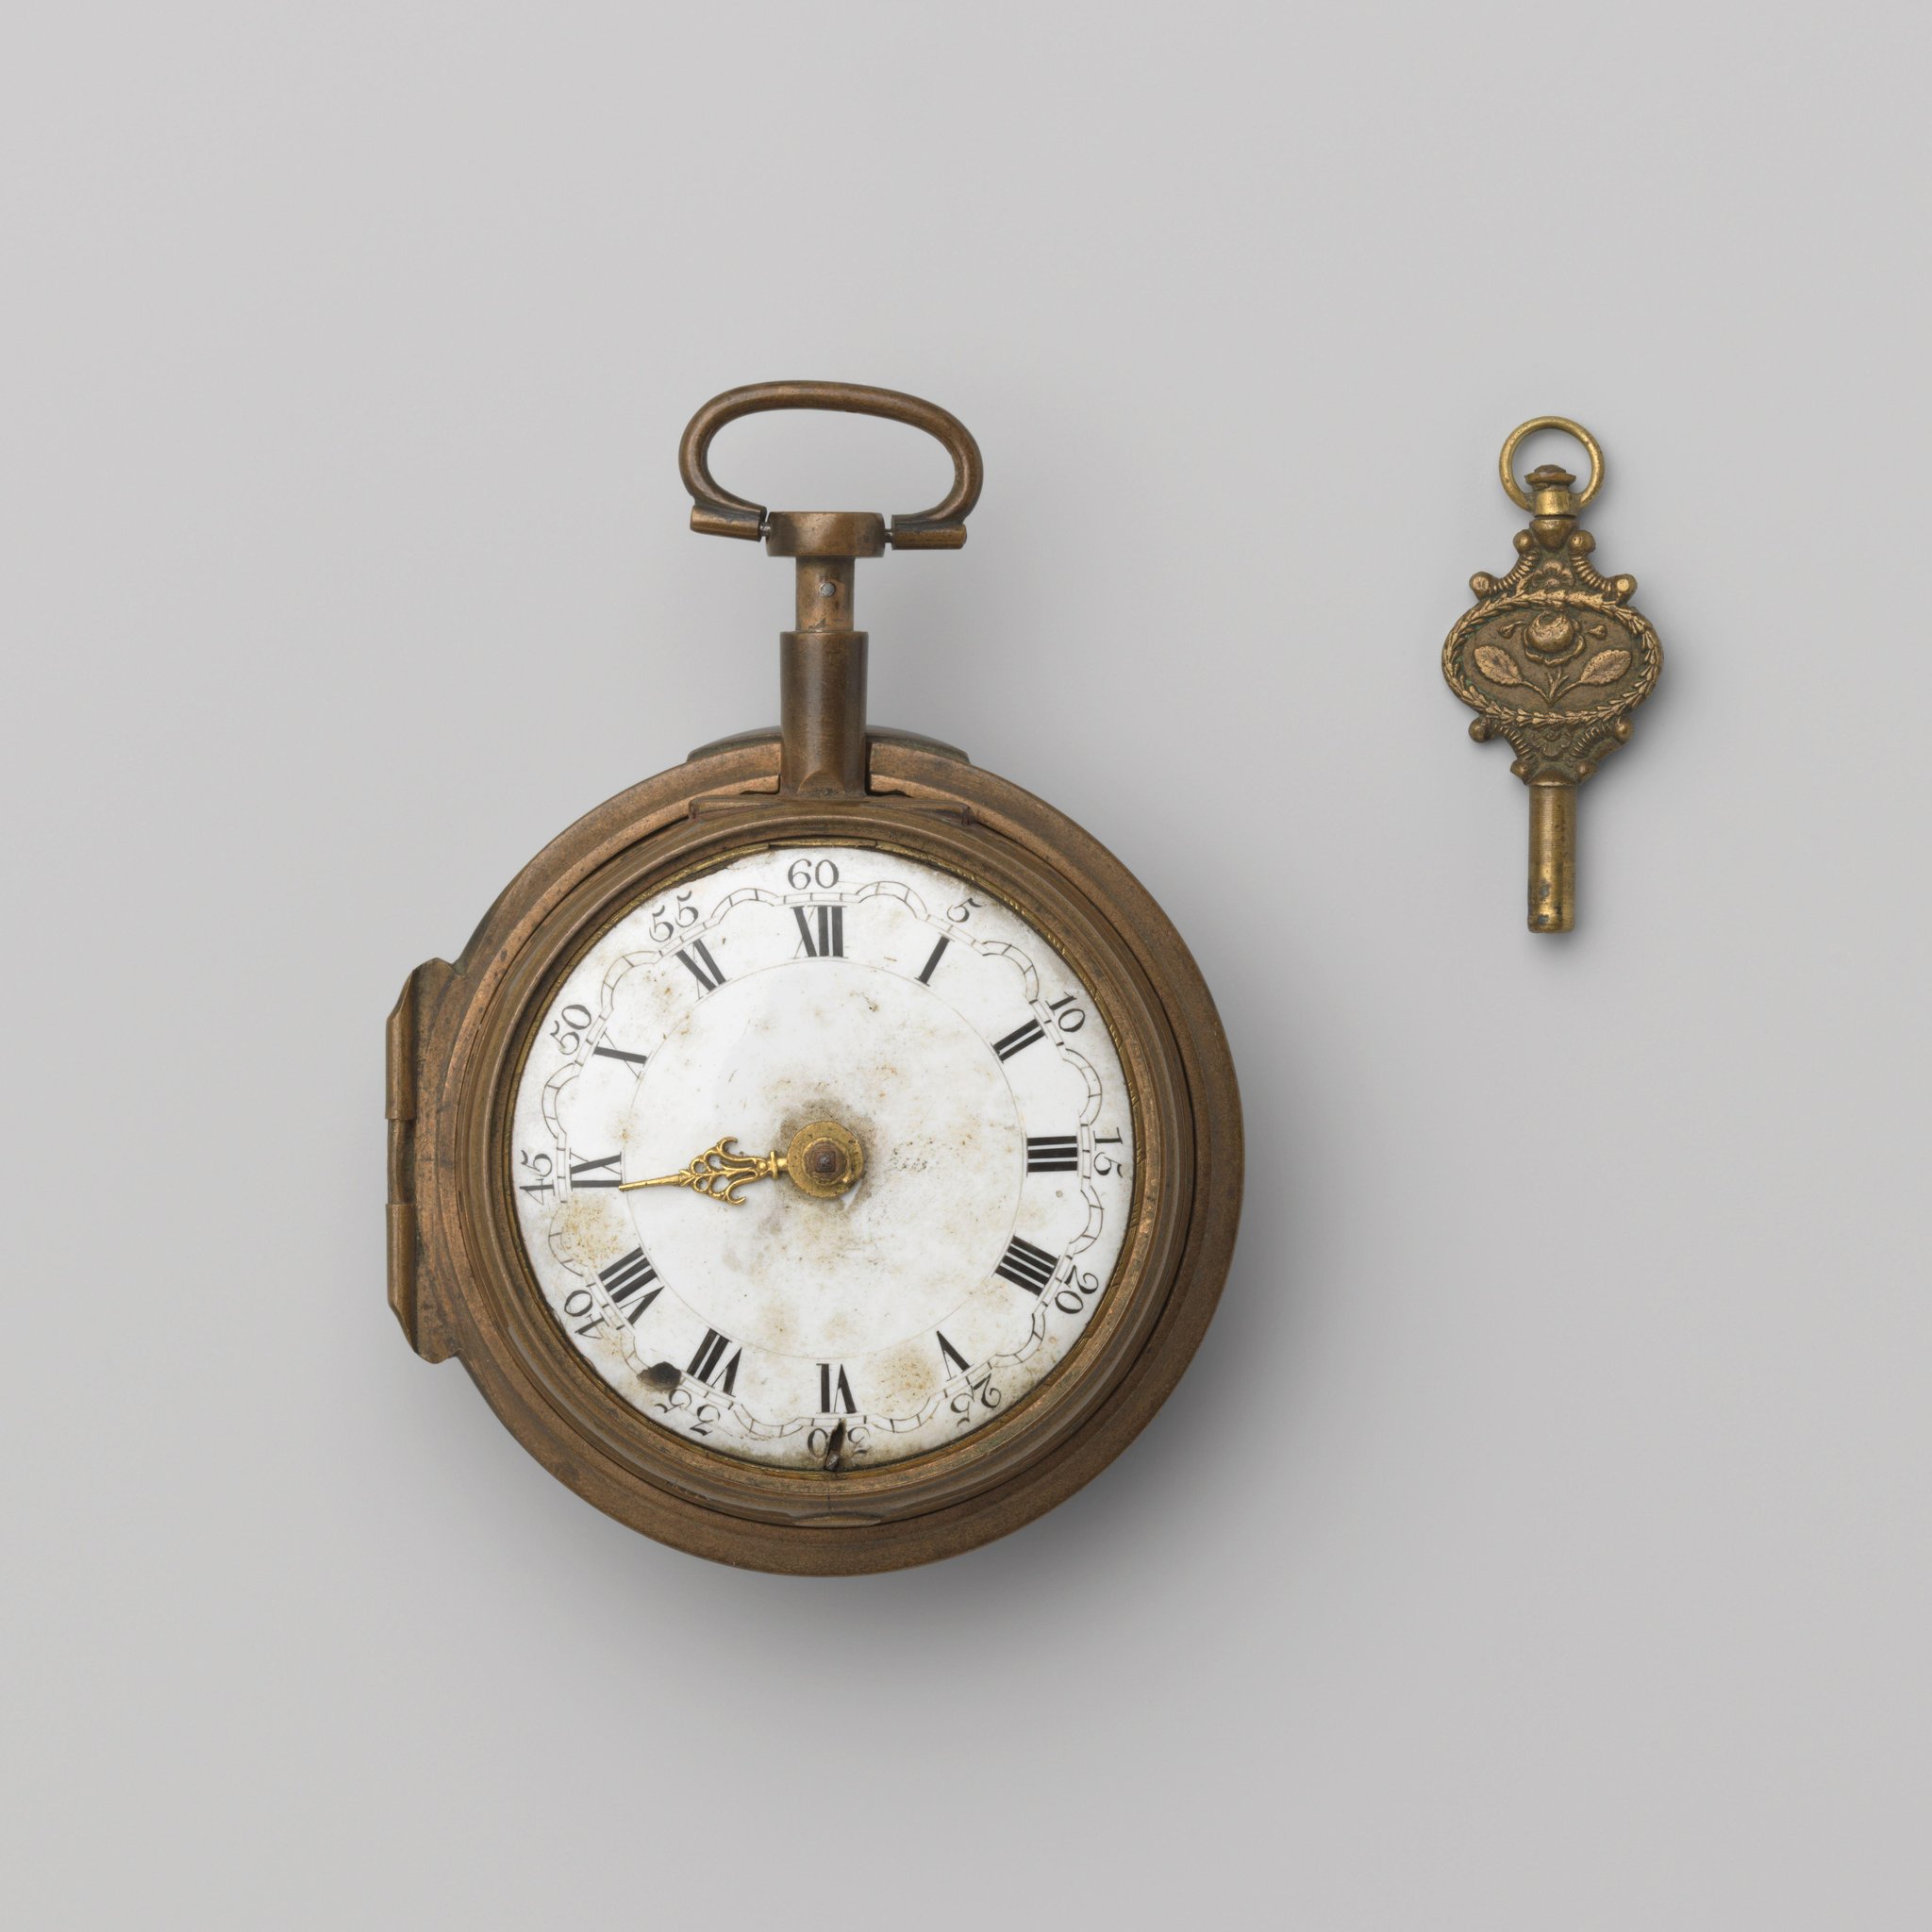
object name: pocket watch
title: Zakhorloge met witgeëmailleerde wijzerplaat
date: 1763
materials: copper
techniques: gilding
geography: amsterdam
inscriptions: retailer's mark: ‘J.C. Göller, Horlogemaker, Nieuwmarkt bij de Bavorde steeg 24, Amsterdam.’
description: Verguld koperen repetitiehorloge, met witgeëmailleerde wijzerplaat. Met sleuteltje aan touw.